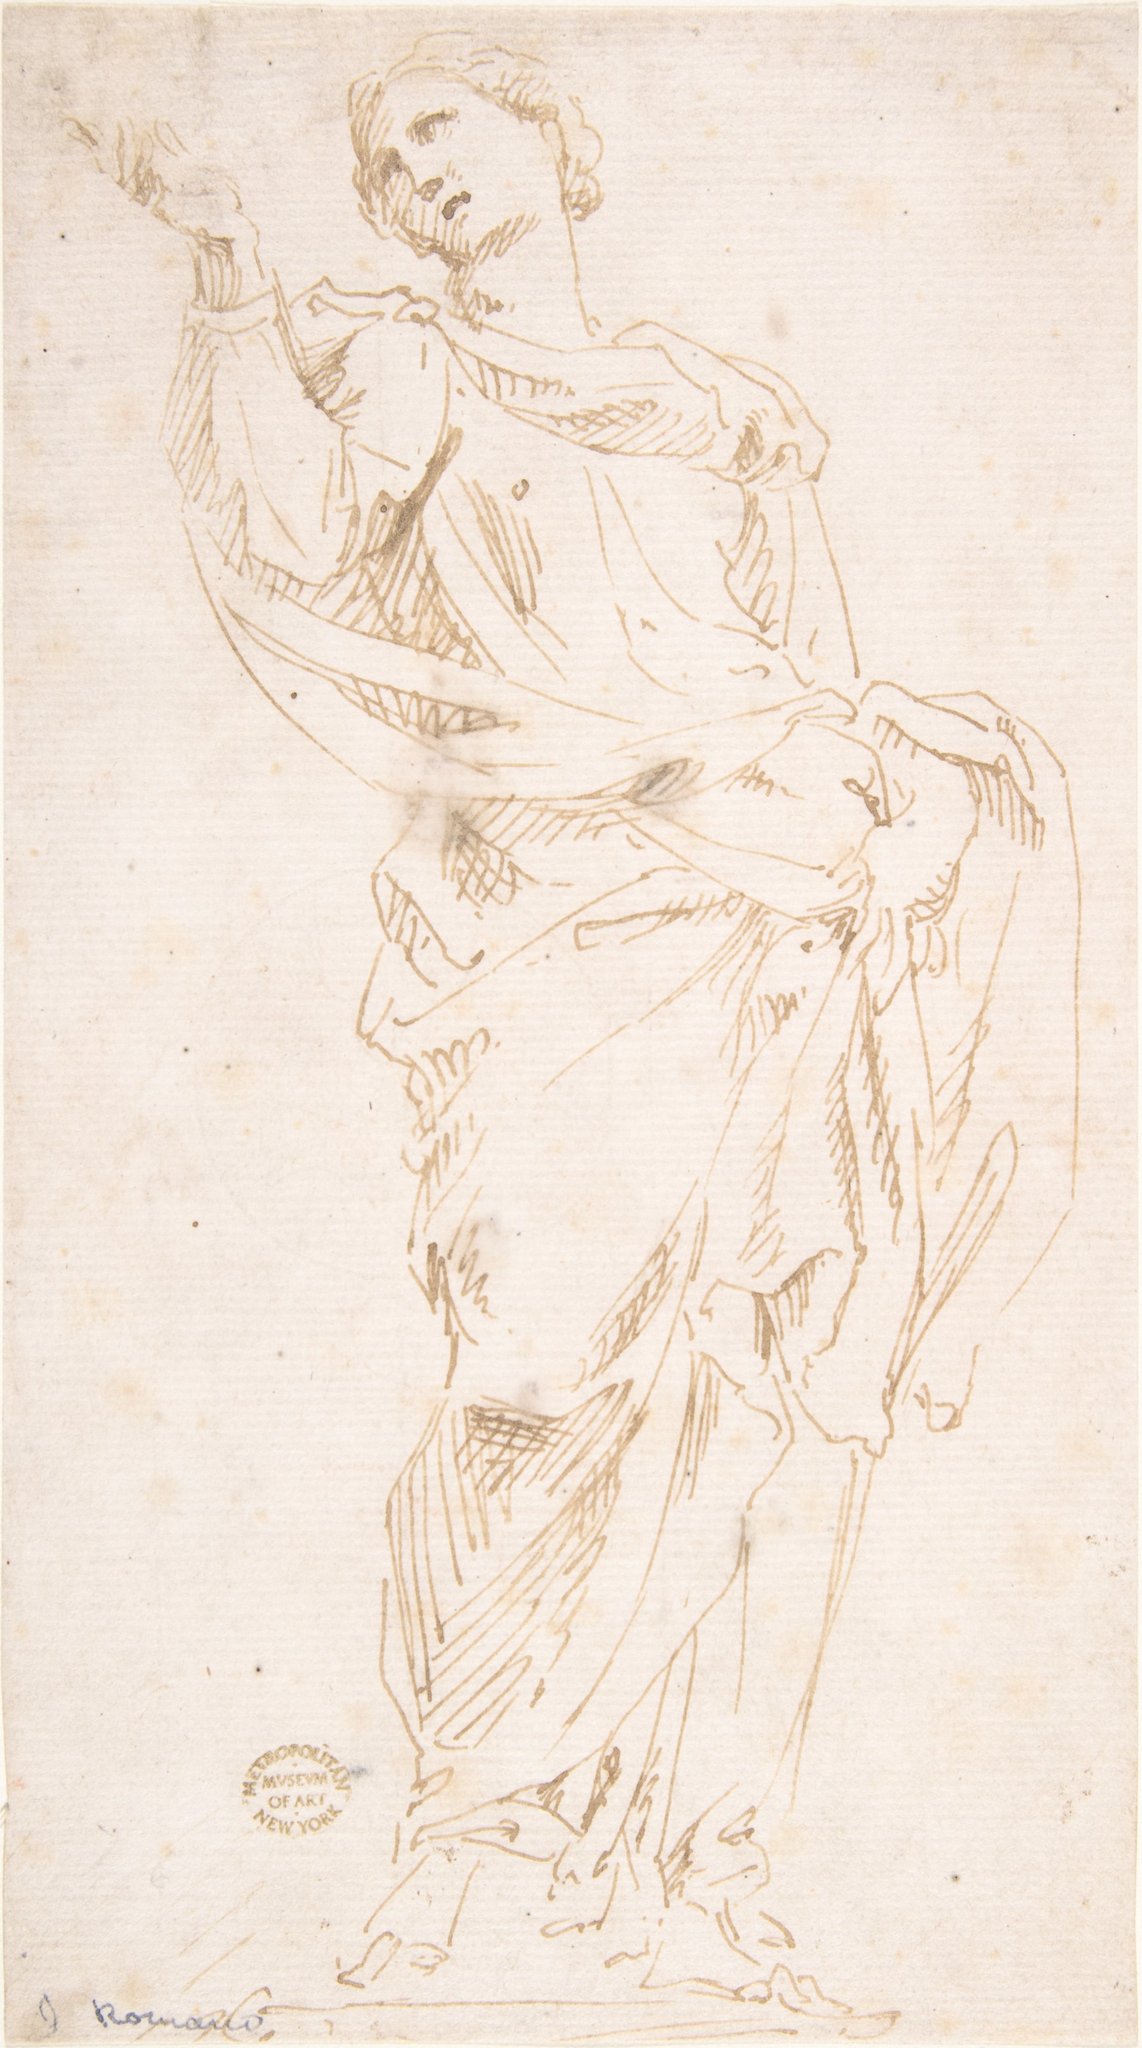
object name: drawing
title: Draped Figure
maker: anonymous, italian, 16th century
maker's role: artist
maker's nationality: italian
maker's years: 1550-1600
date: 1501-1600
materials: ink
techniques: pen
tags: human figures